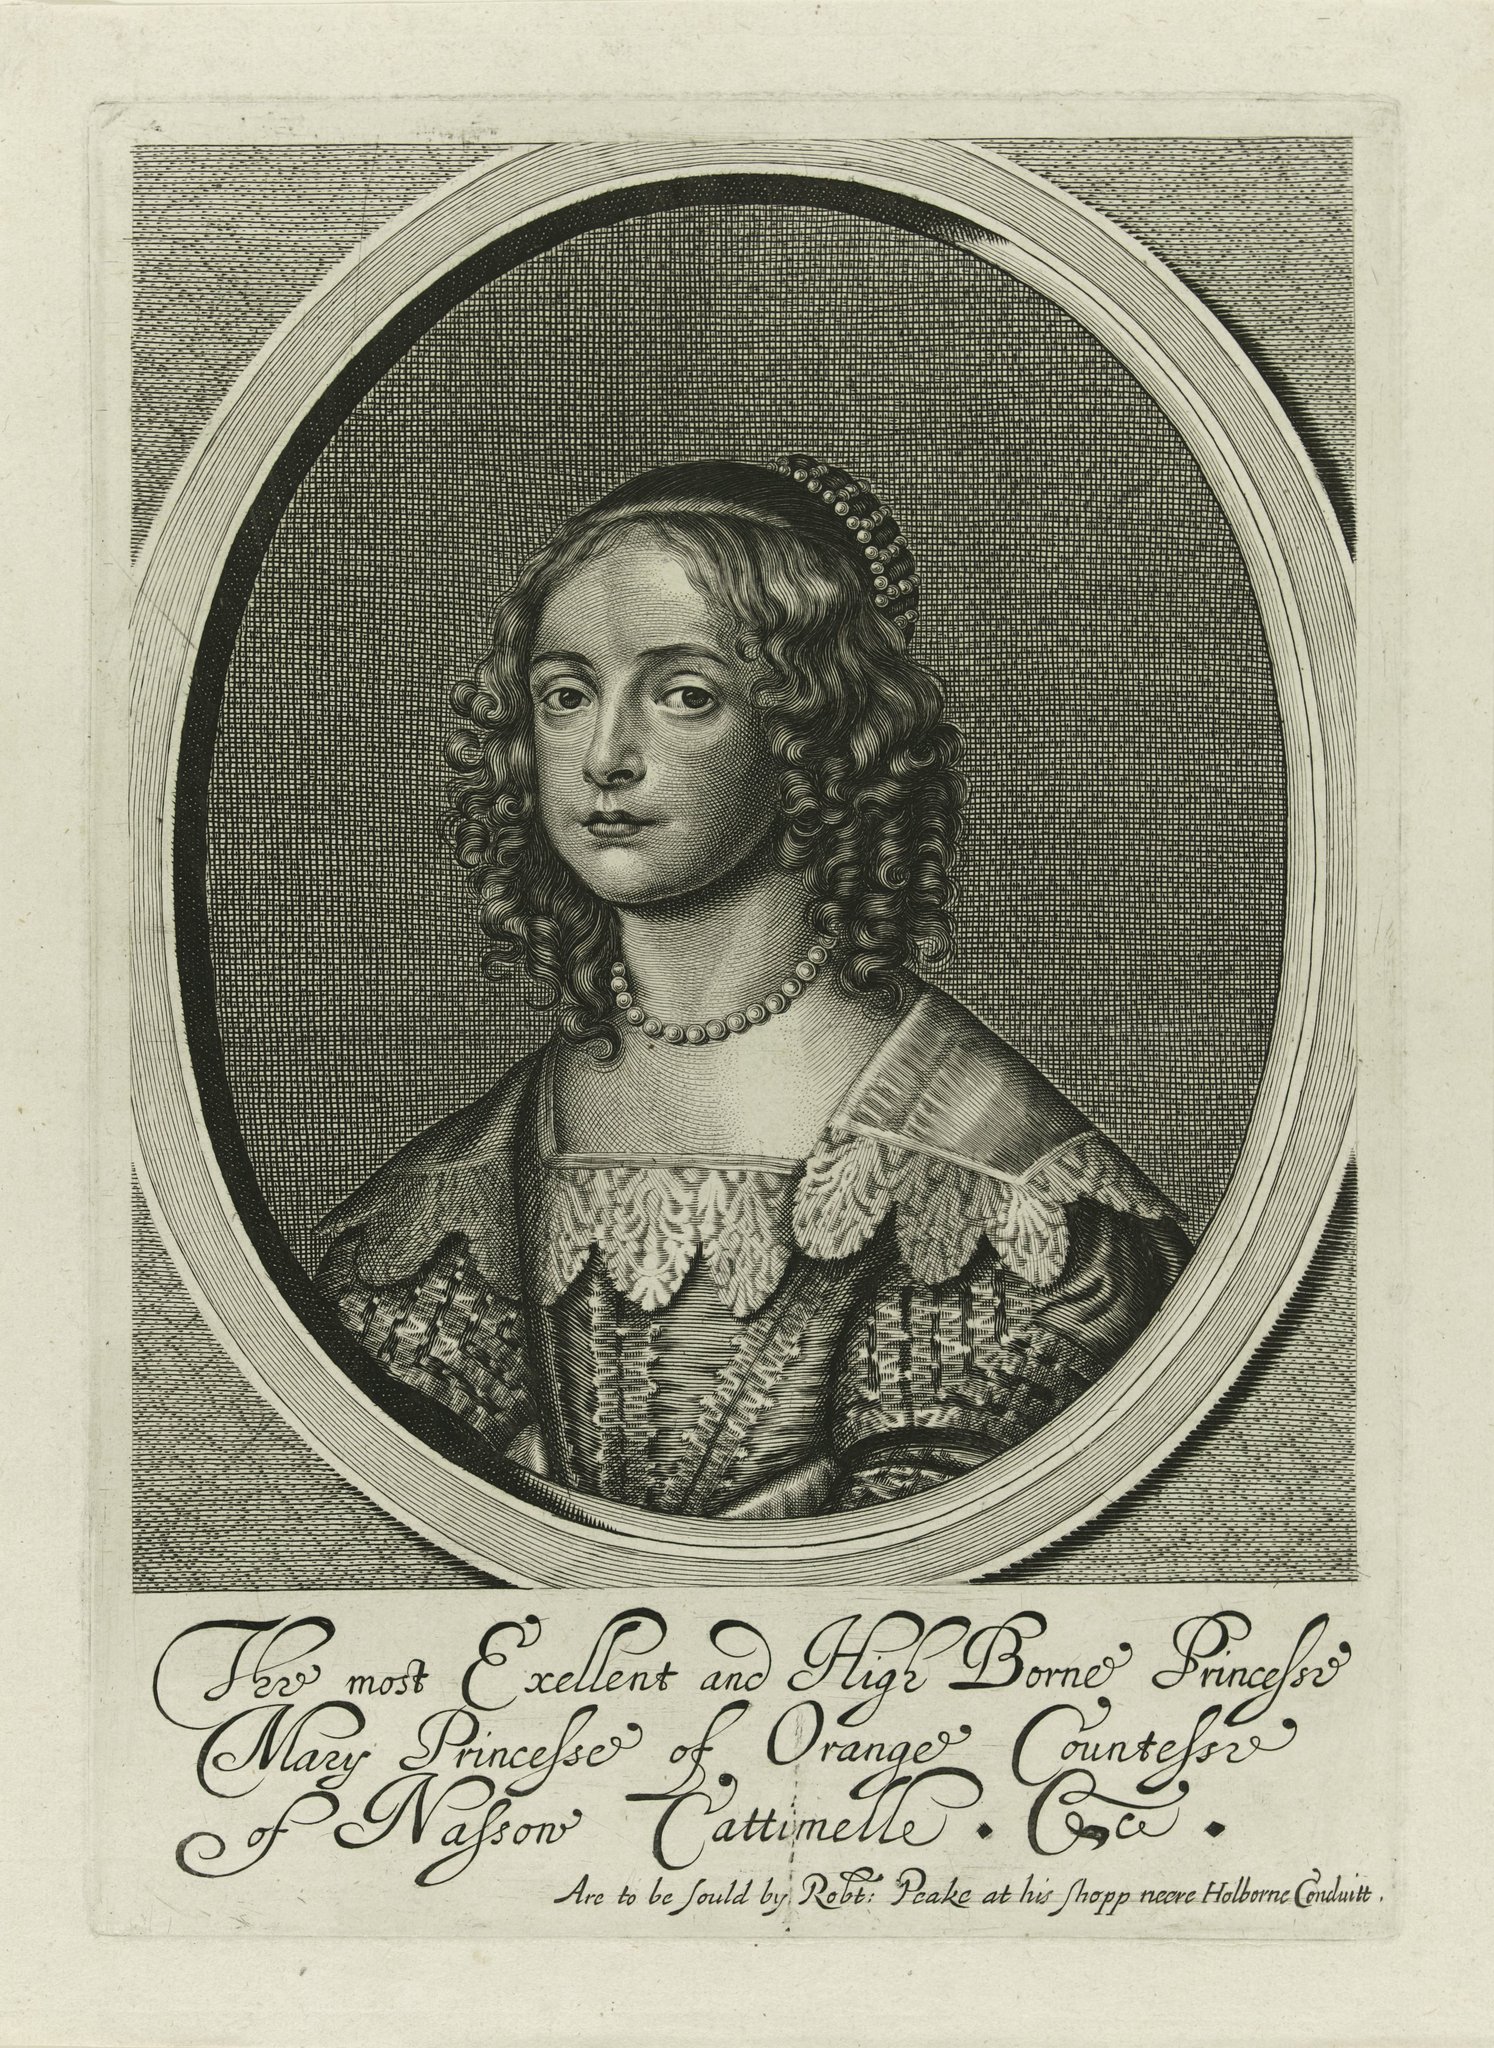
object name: print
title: Portret van Maria Henrietta Stuart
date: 1640-1667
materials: paper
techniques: engraving, etching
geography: london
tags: mary henrietta stuart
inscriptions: collector's mark: Lugt 2760, collector's mark: Lugt 2228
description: Portret van Maria Henrietta in een ovaal. In de ondermarge drie regels Engelse tekst.